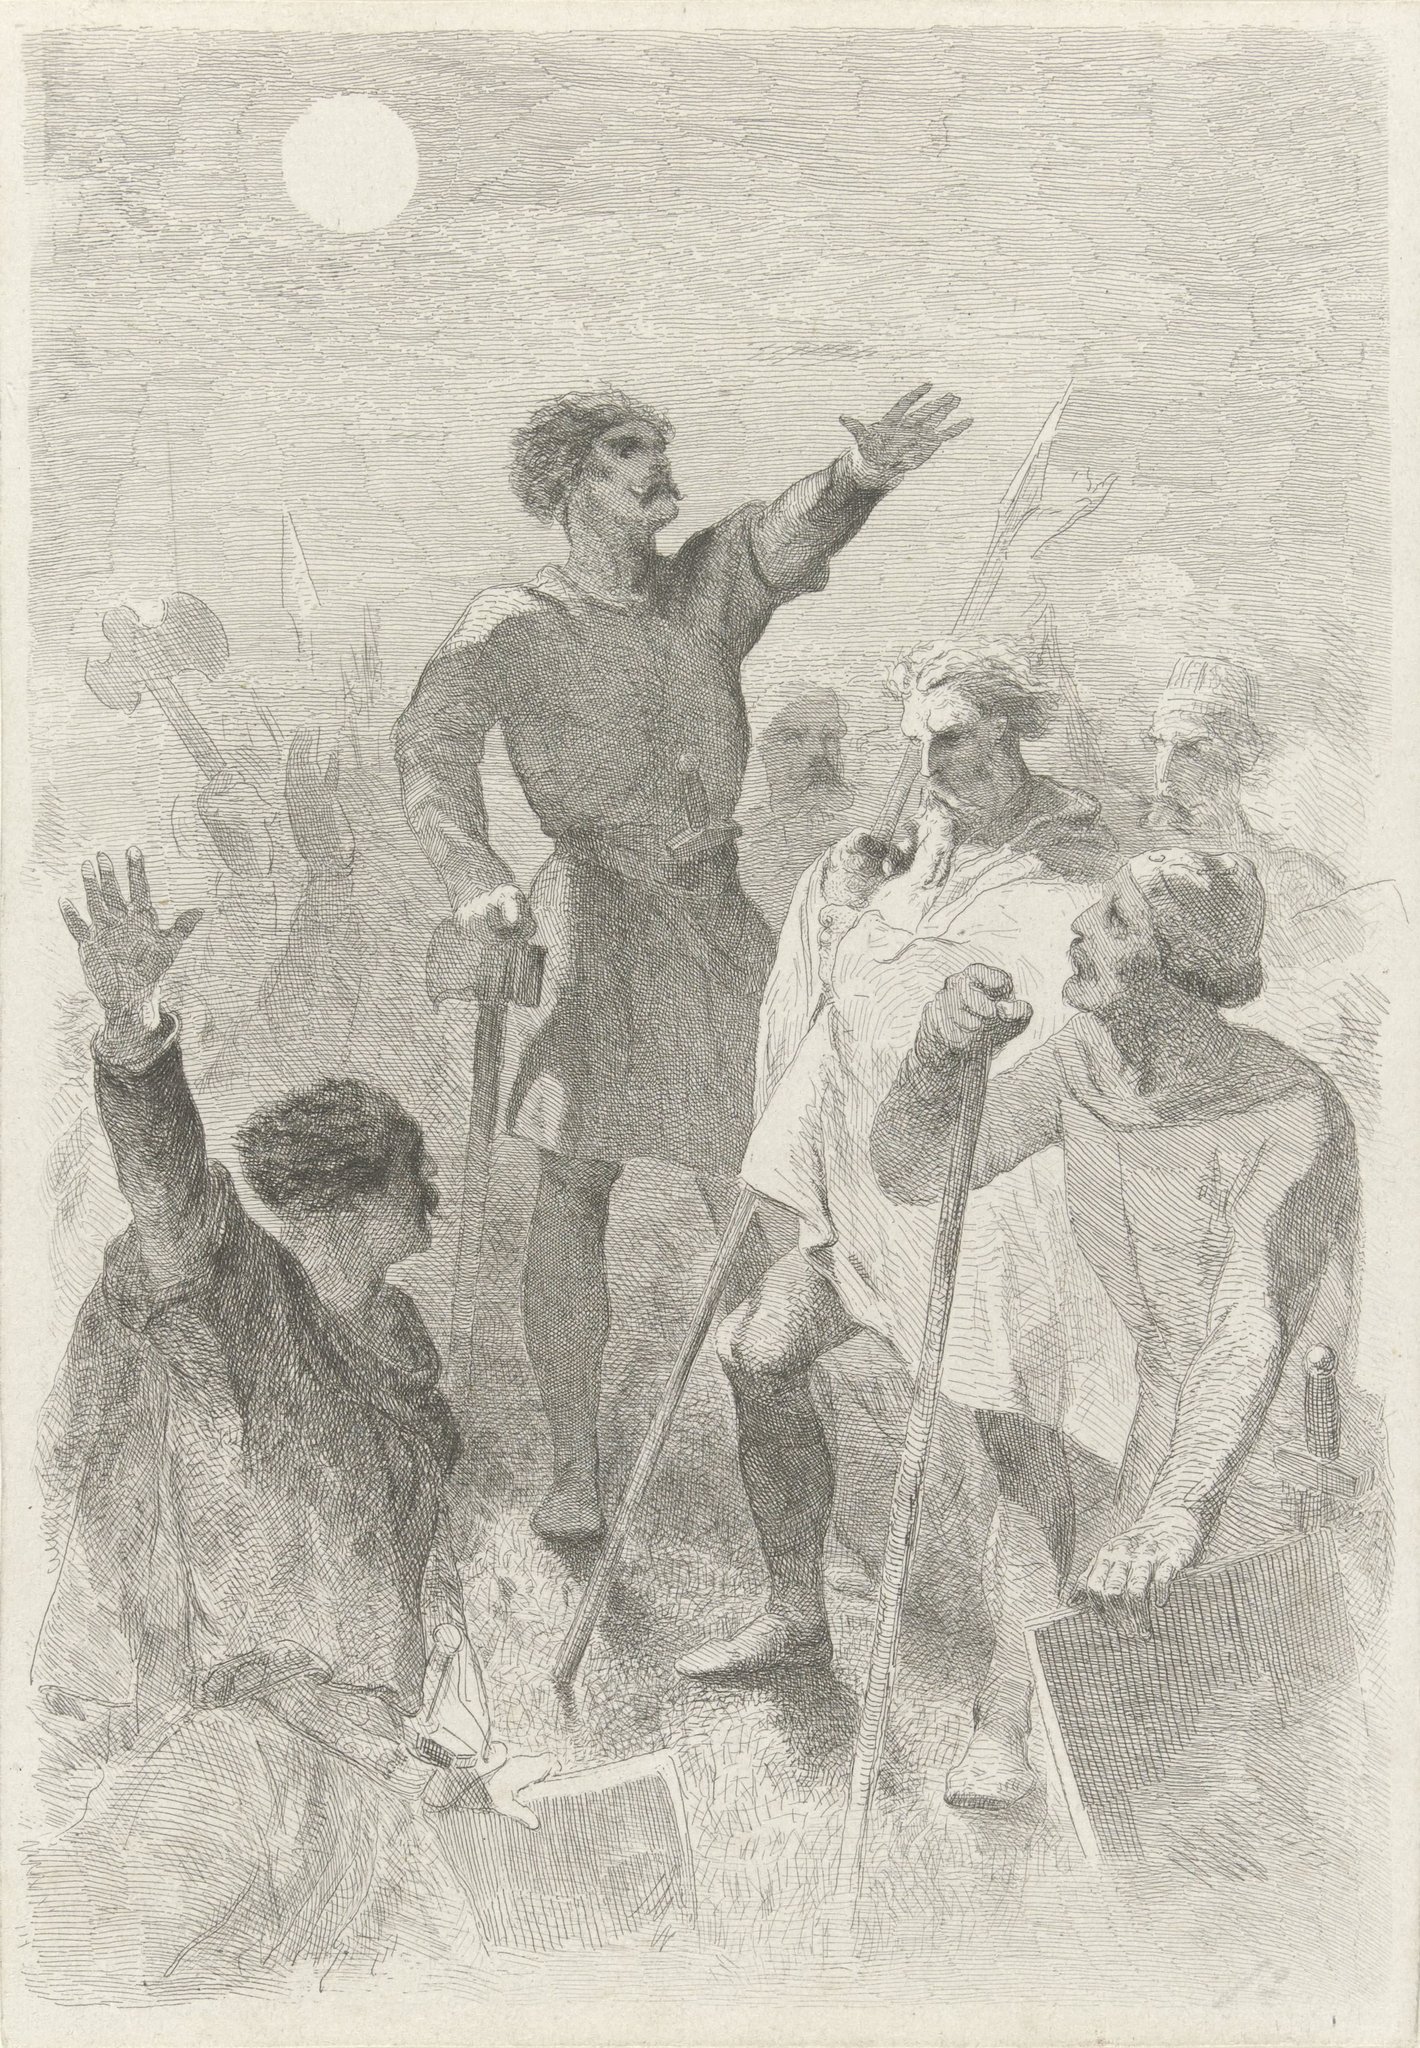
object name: print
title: Wilfried omringd door zijn krijgers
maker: charles rochussen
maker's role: draughtsman, painter, print maker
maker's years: 1814-1894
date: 1854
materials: paper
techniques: steel etching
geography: amsterdam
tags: the soldier; the soldier's life (+ weapons), military instruction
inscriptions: collector's mark: Lugt 2228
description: Wilfried is door zijn krijgers omringd. Illustratie van een scène uit een boek met gedichten genaamd 'Helene'.